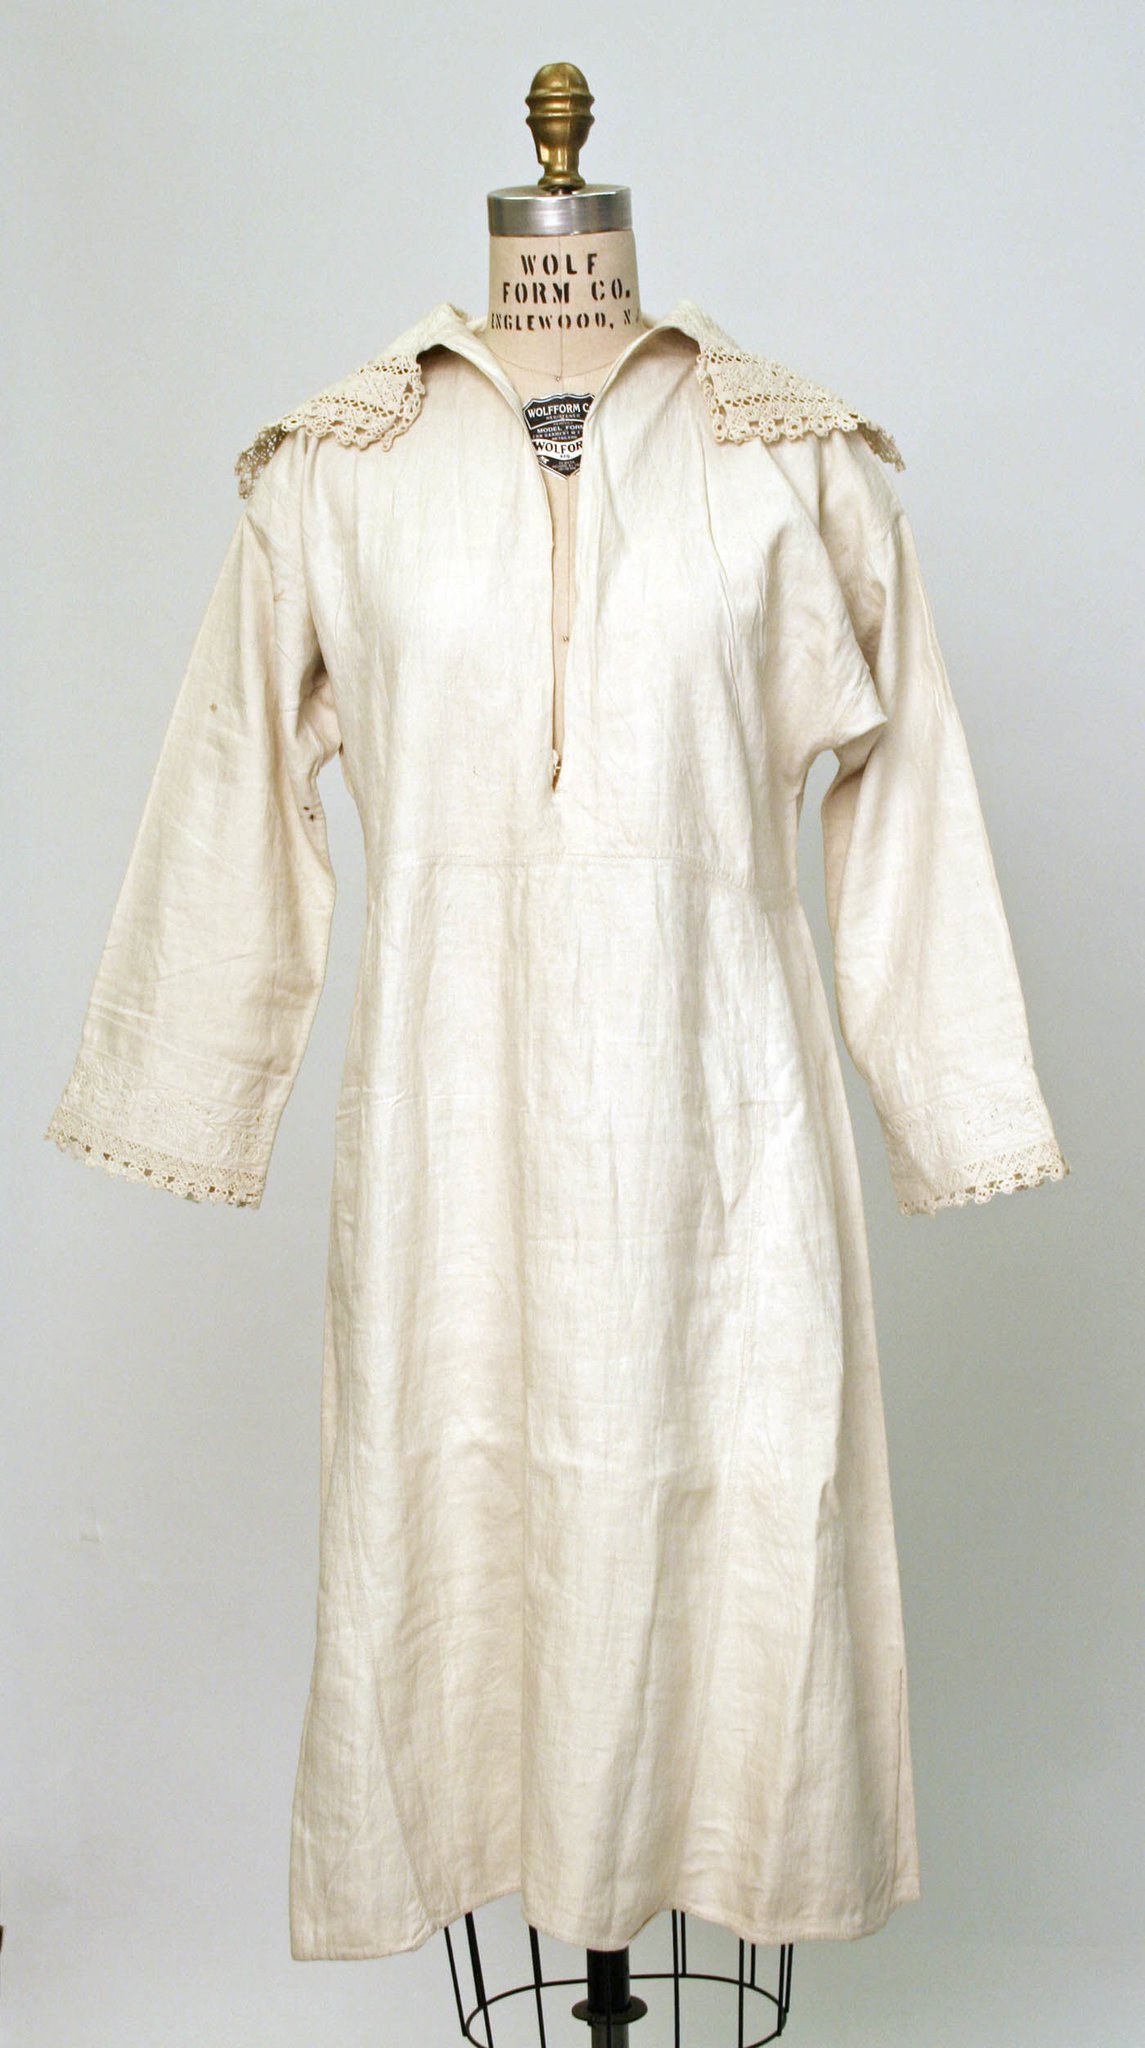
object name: chemise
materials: linen